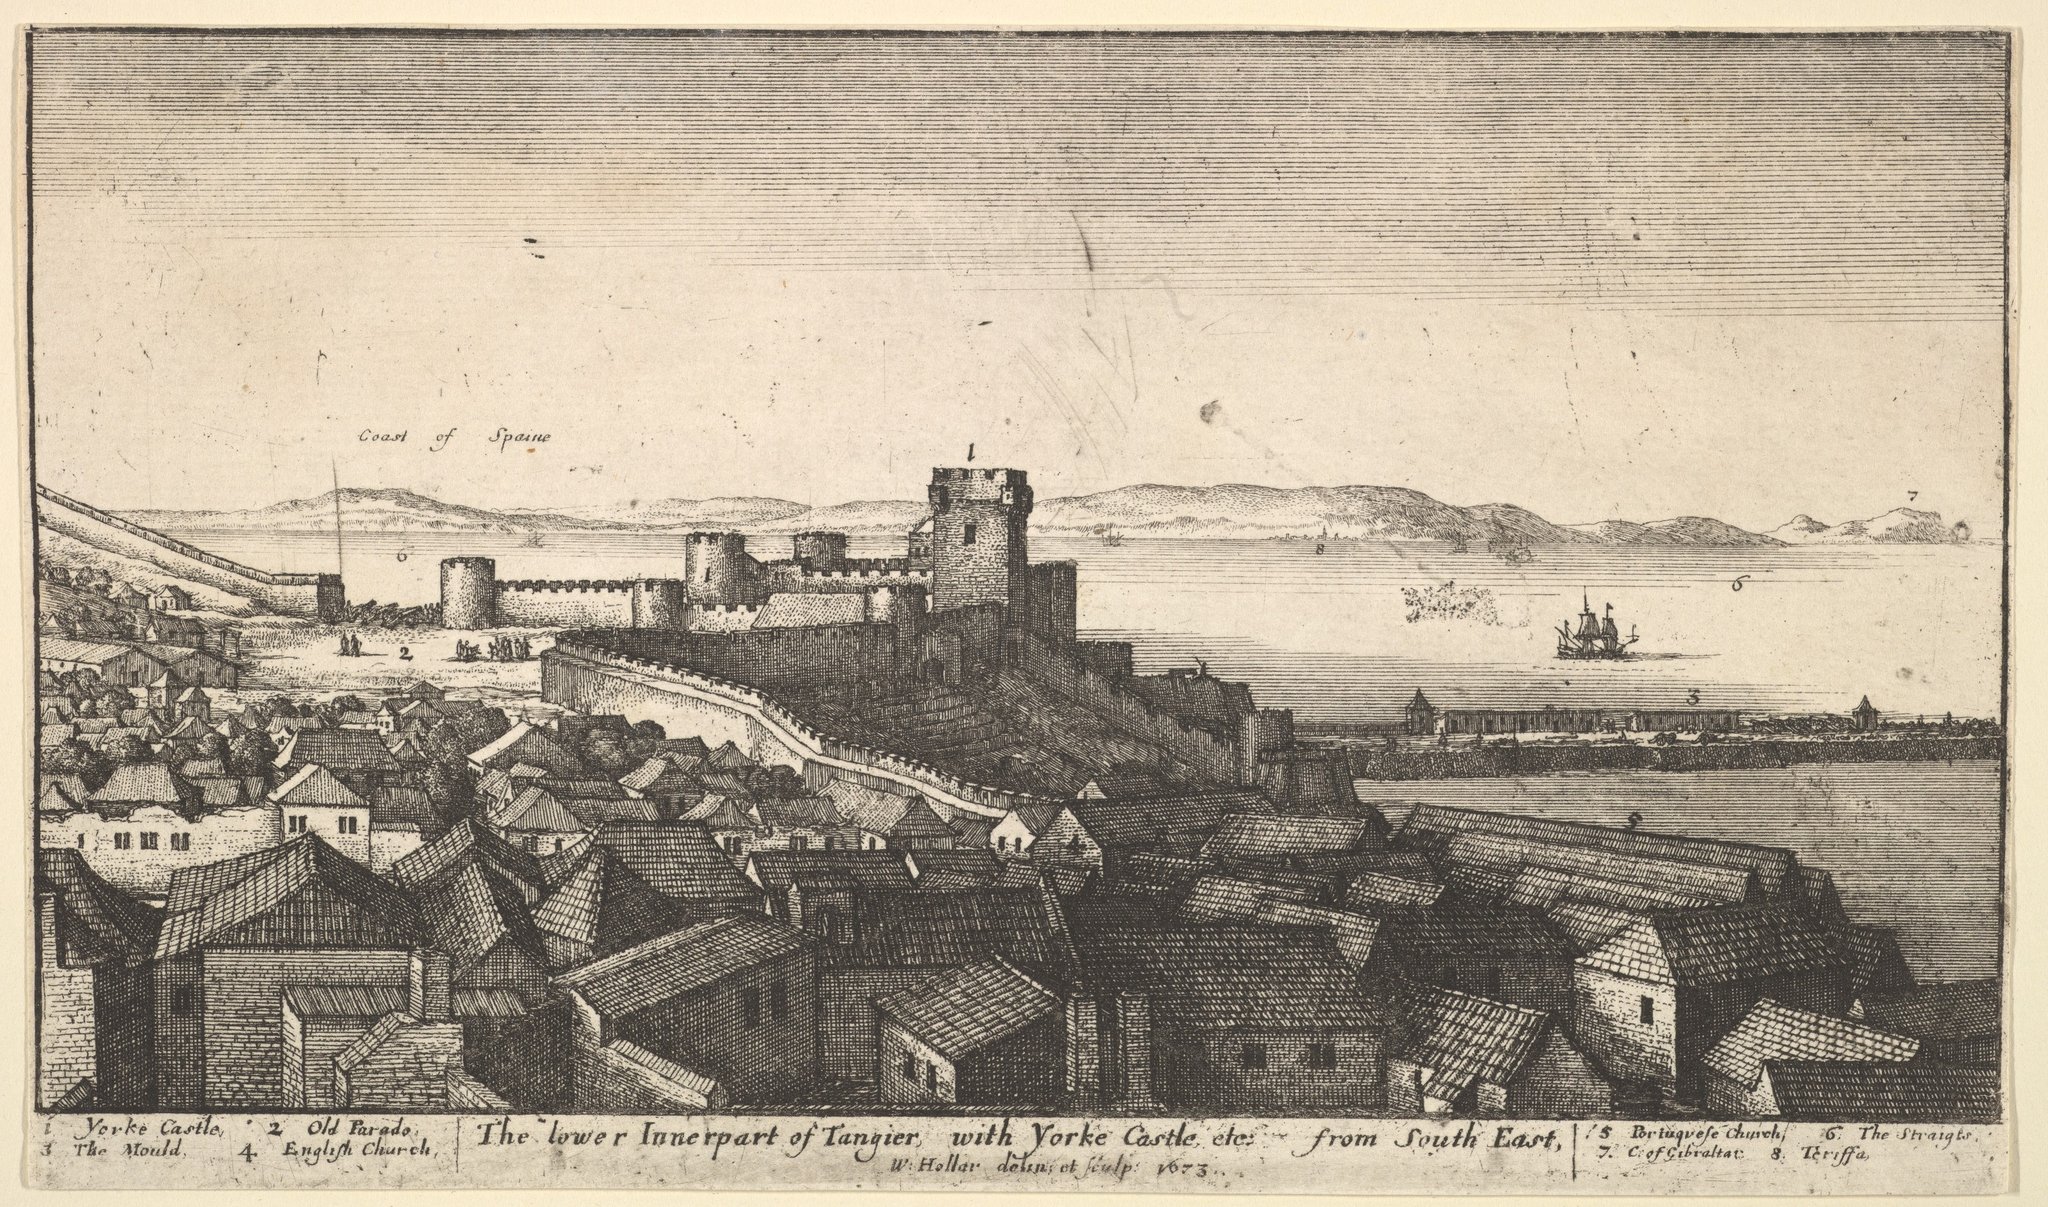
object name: print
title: The lower inner part of Tangier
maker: wenceslaus hollar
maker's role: artist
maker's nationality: bohemian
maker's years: 1607-1677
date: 1673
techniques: etching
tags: castles,cities